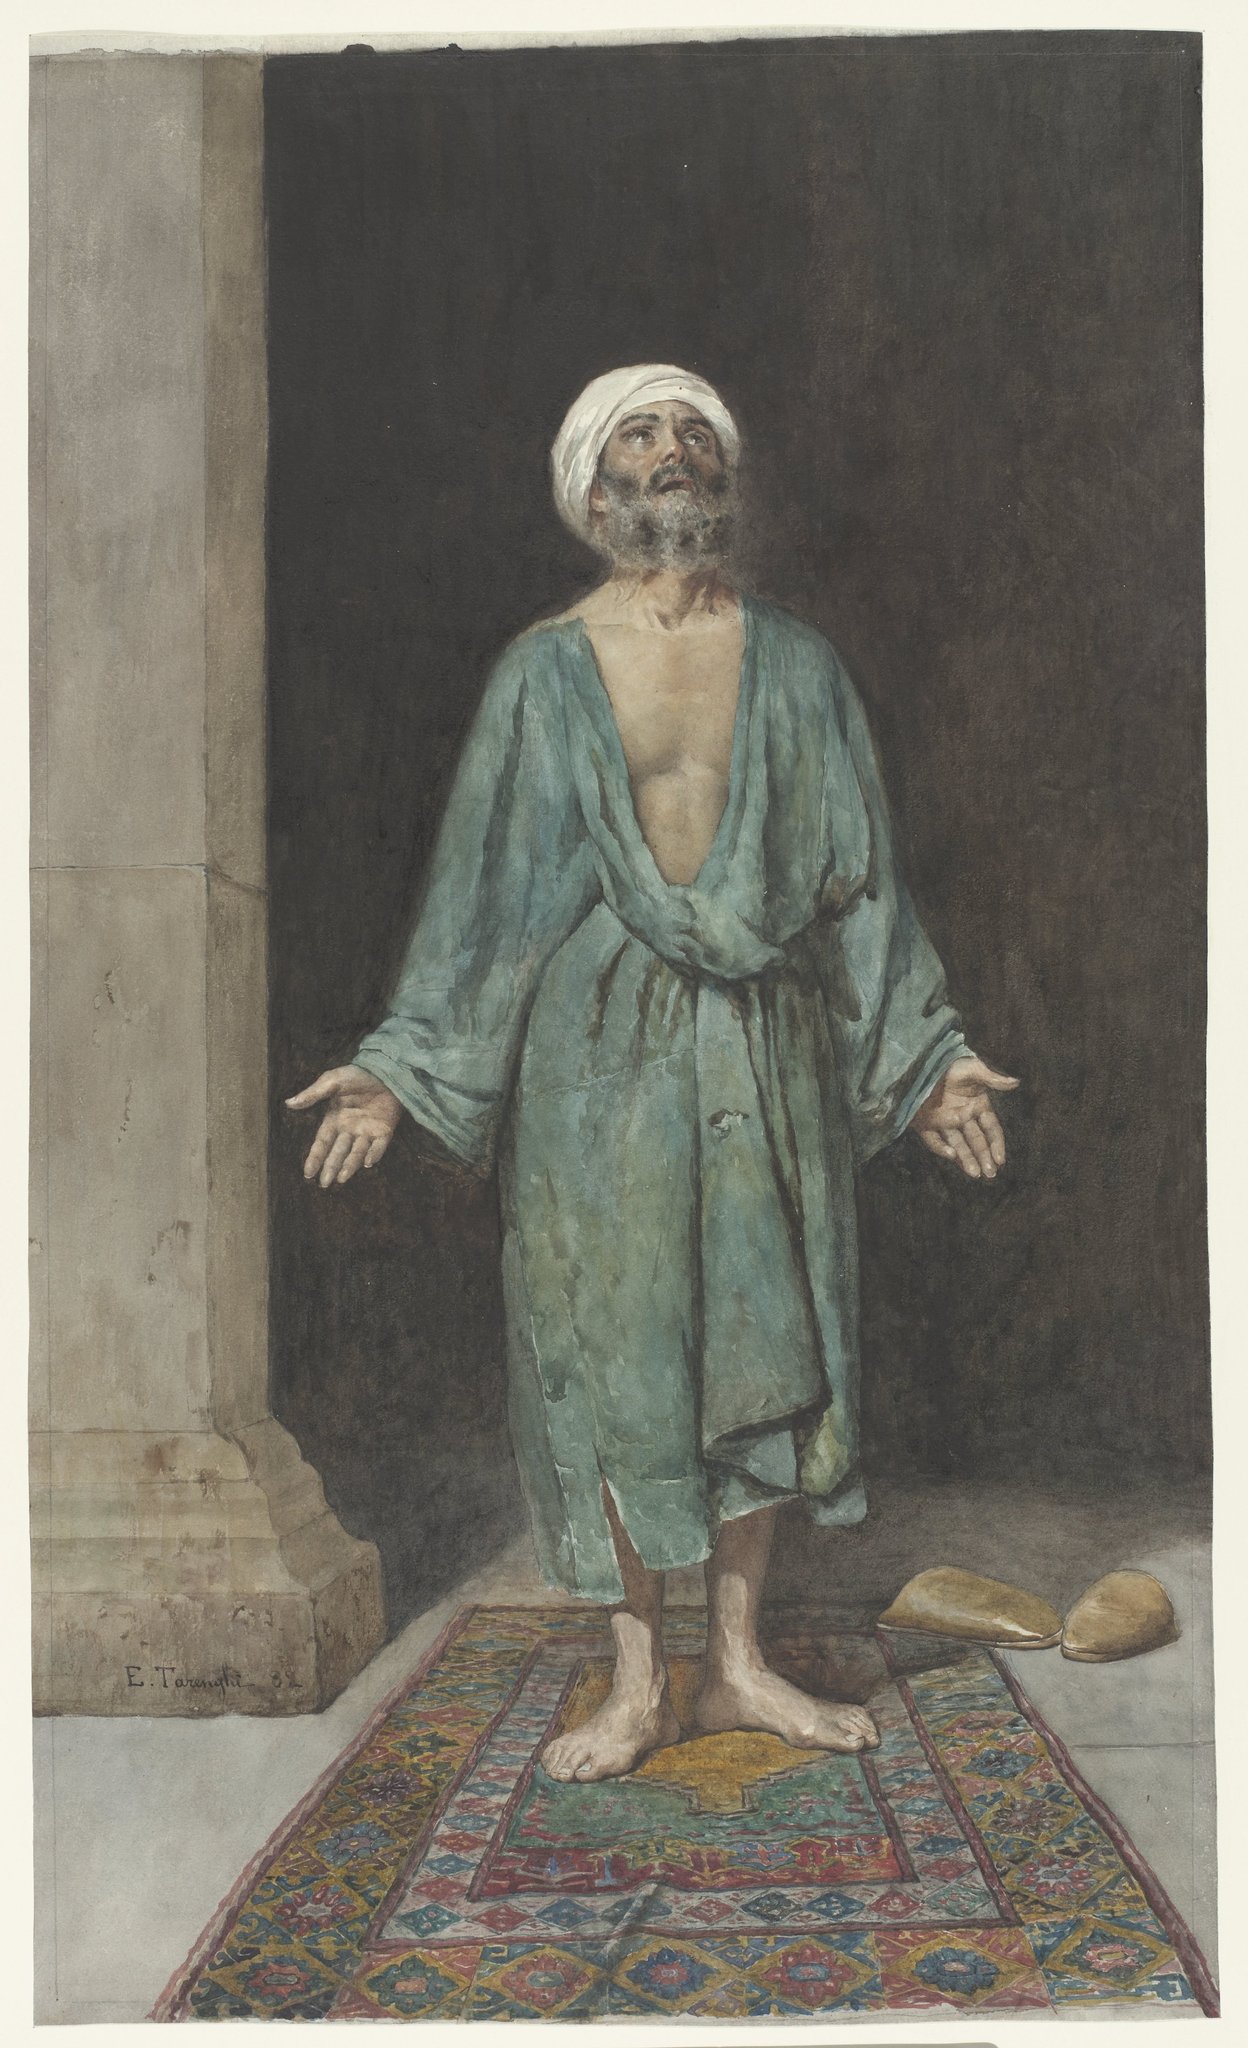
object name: drawing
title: Een biddende muzelman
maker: enrico tarenghi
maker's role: draughtsman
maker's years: 1848-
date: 1882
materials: paper, watercolor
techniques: brush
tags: asiatic races and peoples, prayer ~ islam, mohammedanism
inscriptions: date: ‘82’